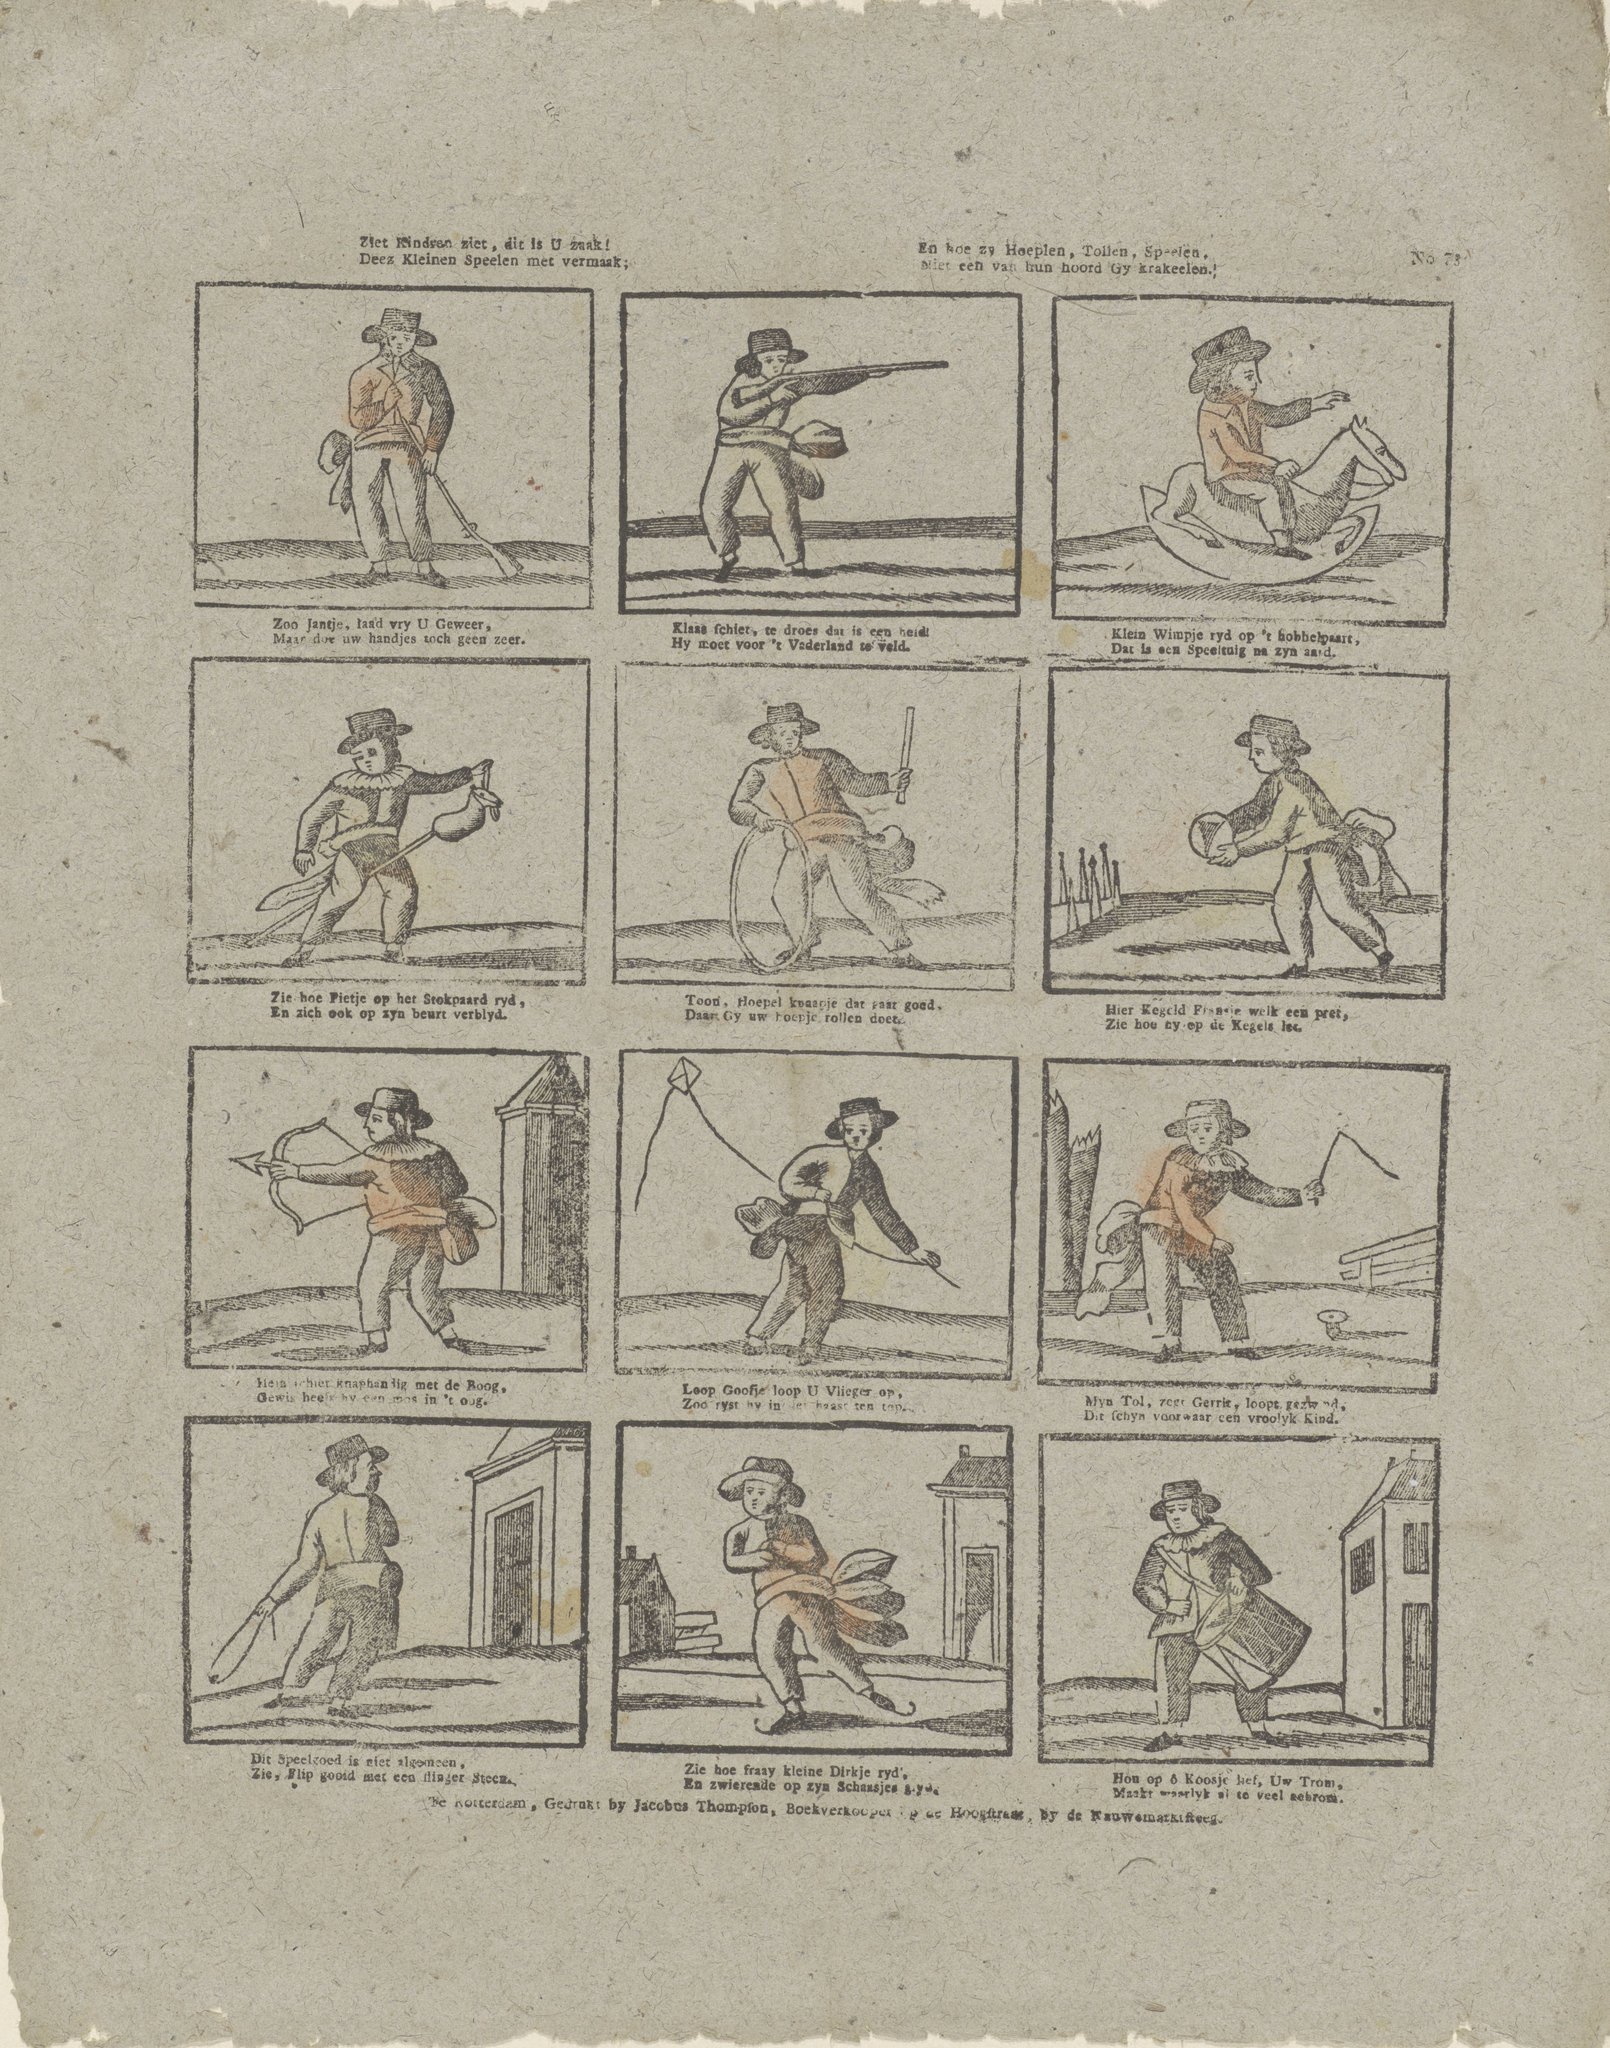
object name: print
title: Ziet kindren ziet, dit is u zaak! / Deez kleinen speelen met vermaak; / En hoe zy hoeplen, tollen, speelen, / niet een van hun hoord gy krakeelen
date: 1791-1812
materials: paper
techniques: colour, letterpress printing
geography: netherlands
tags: children's games and plays, bowling games (children's games), (flying a) kite, games using special objects (marbles, top, hoop, etc.), rocking-horse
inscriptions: collector's mark: Lugt 2760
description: Blad met 12 voorstellingen van kinderspelen, waaronder hobbelpaard rijden, hoepelen, kegelen en vliegeren. Onder elke afbeelding een tweeregelig vers. Genummerd rechtsboven: No. 78.